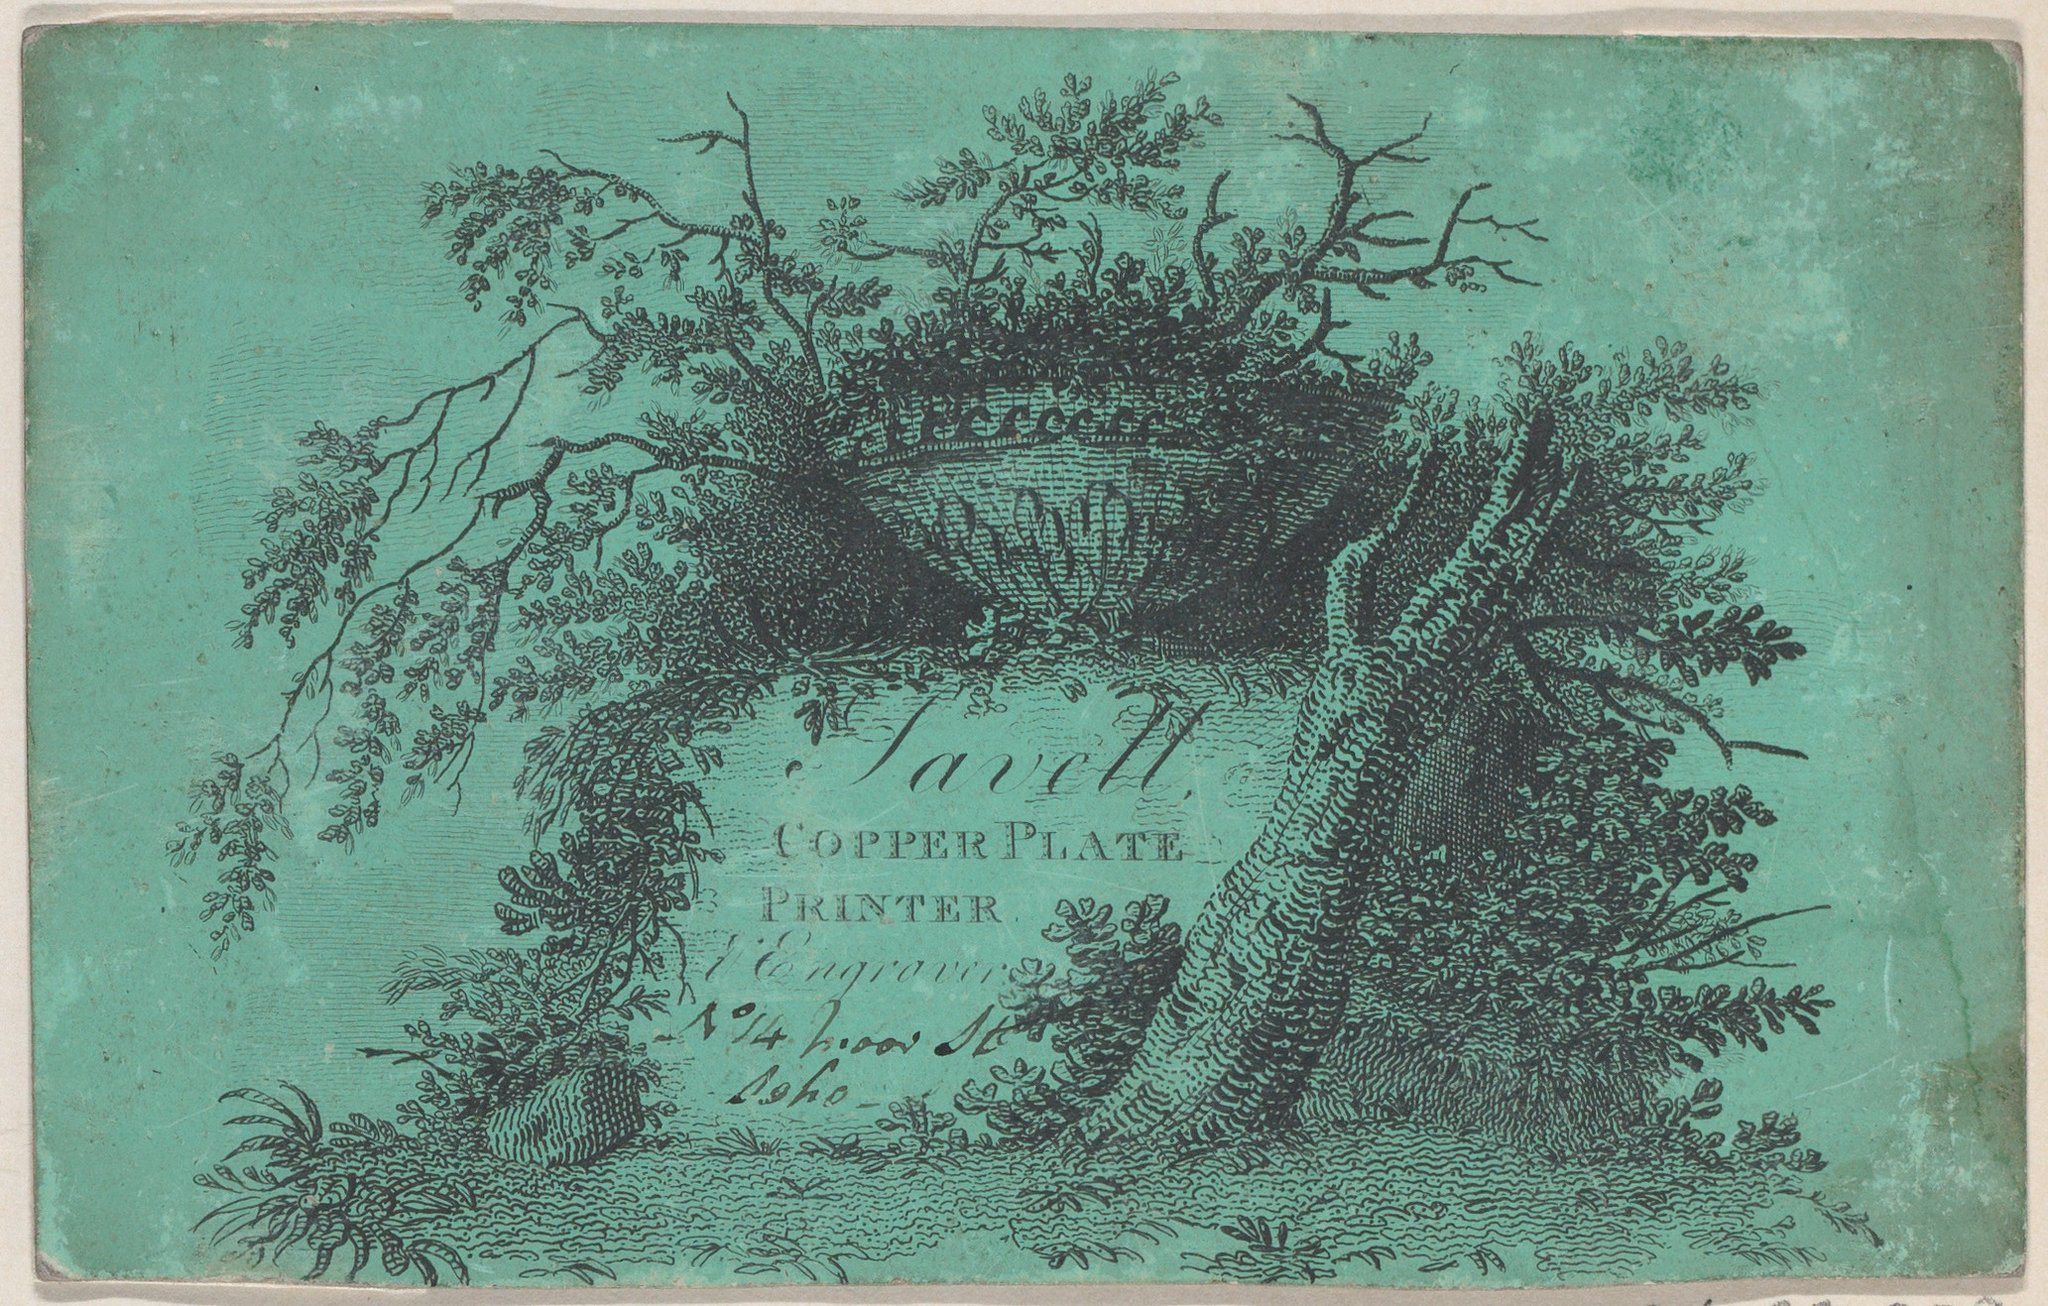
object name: print, trade card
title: Trade Card for Savell, Copper Plate Printer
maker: anonymous, british, 18th century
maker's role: artist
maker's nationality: british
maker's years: 1700-1800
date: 1701-1800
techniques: engraving